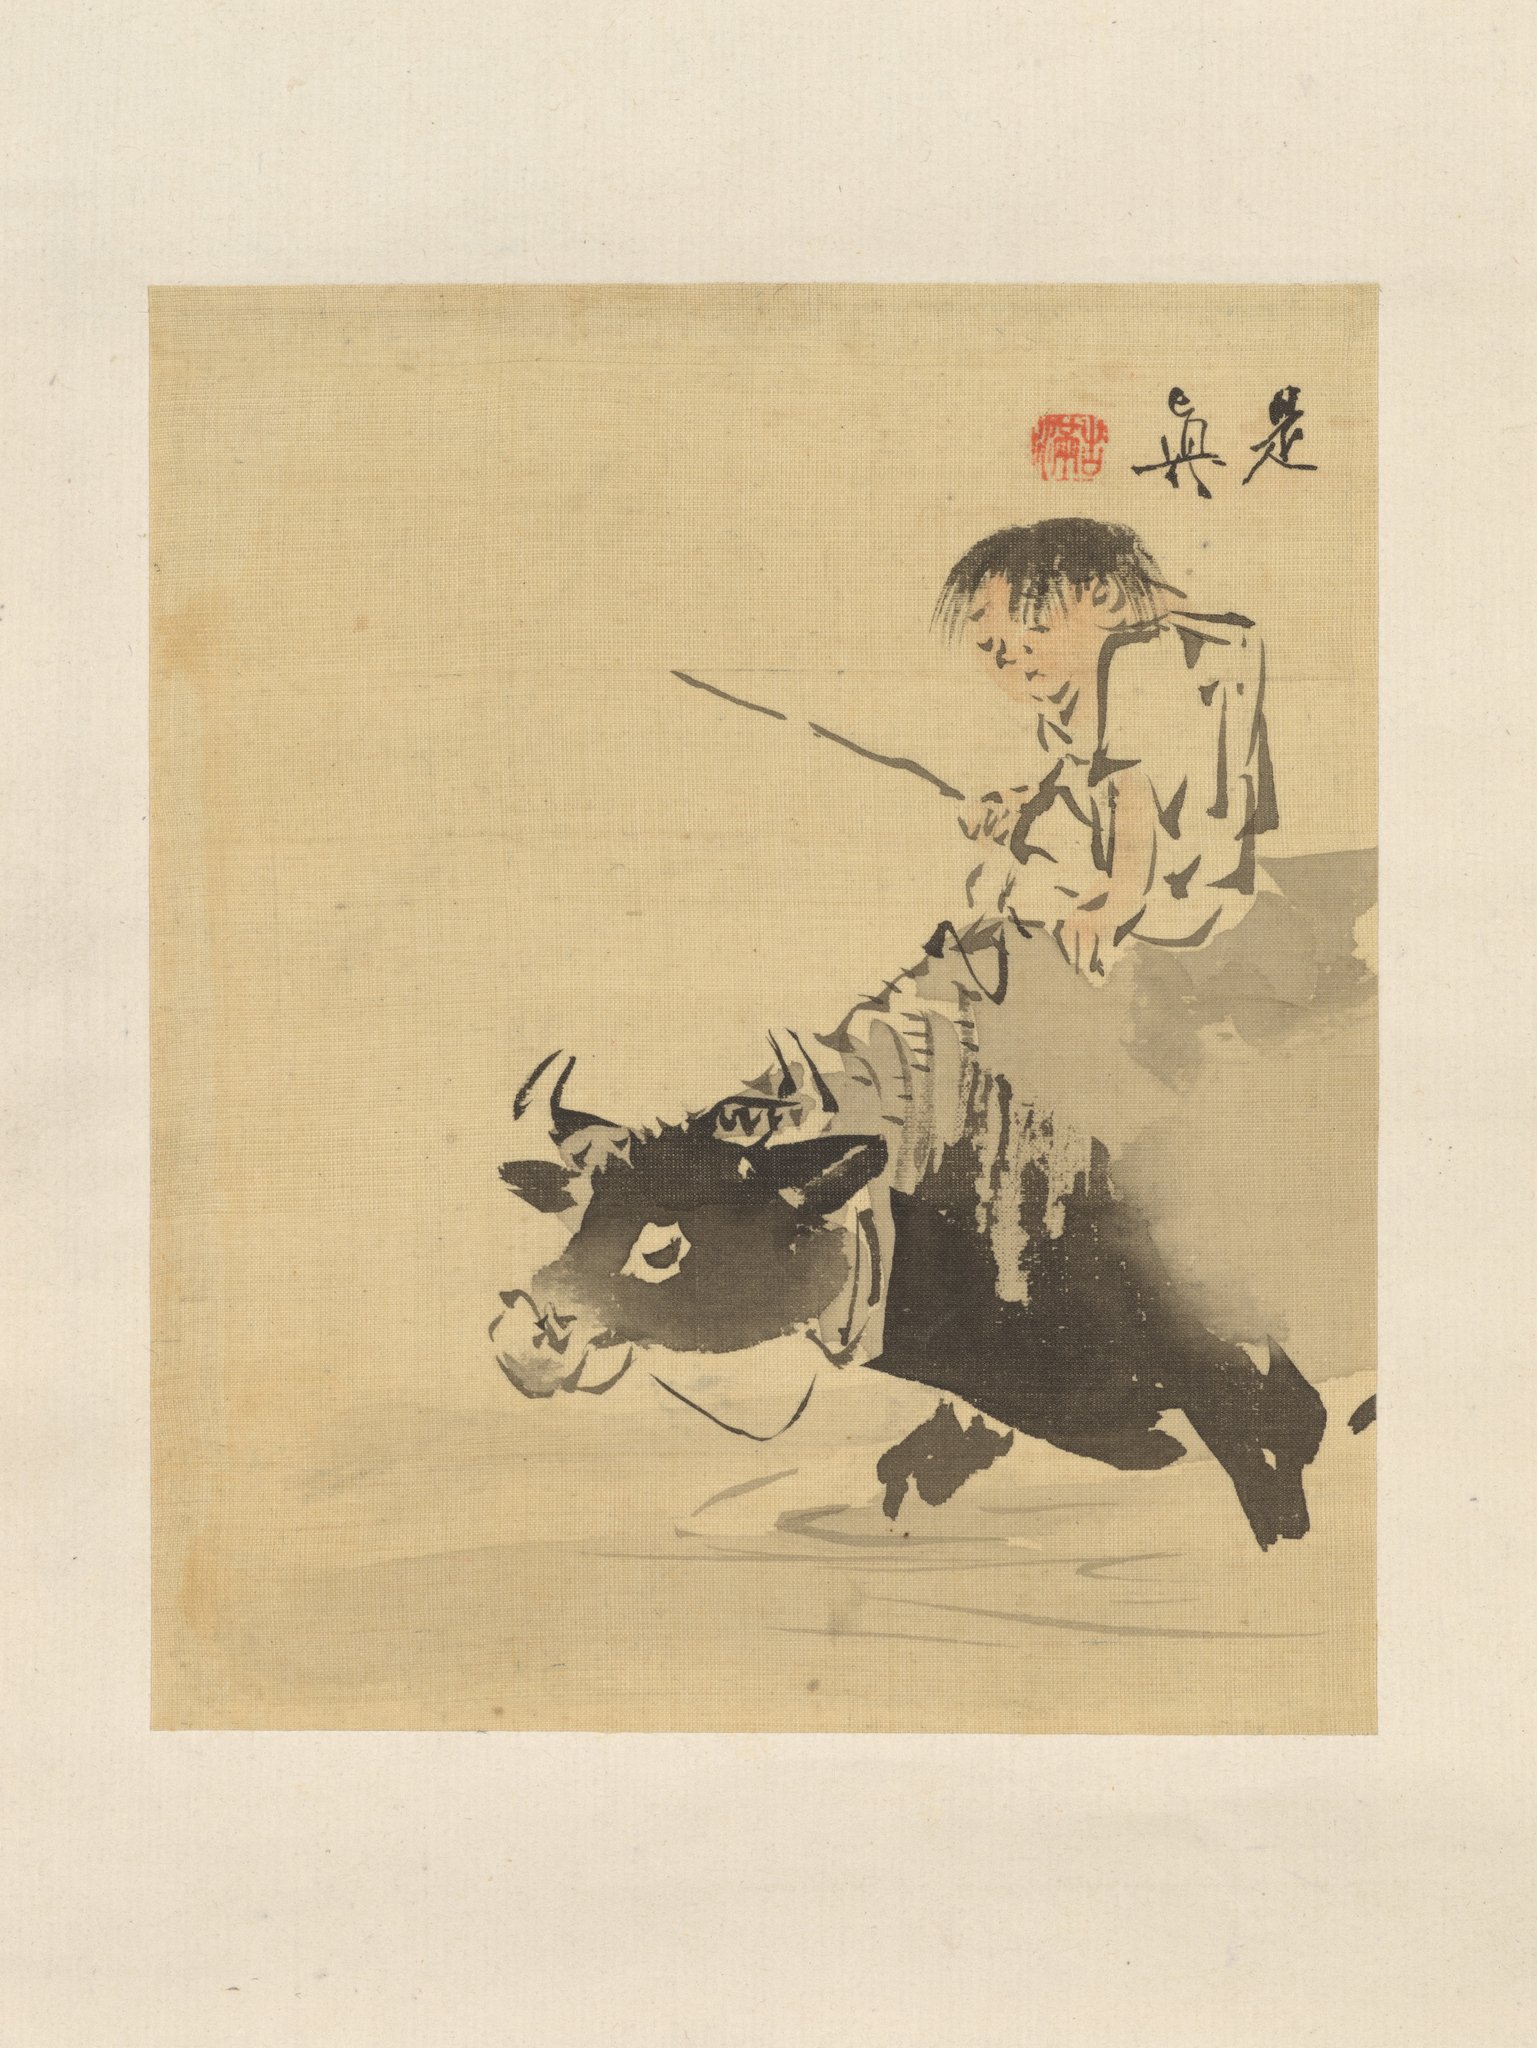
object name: hanging scroll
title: Boy on Ox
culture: japanese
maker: shibata zeshin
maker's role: artist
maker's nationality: japanese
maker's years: 1807-1891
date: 1801-1900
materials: ink, silk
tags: boys,ox